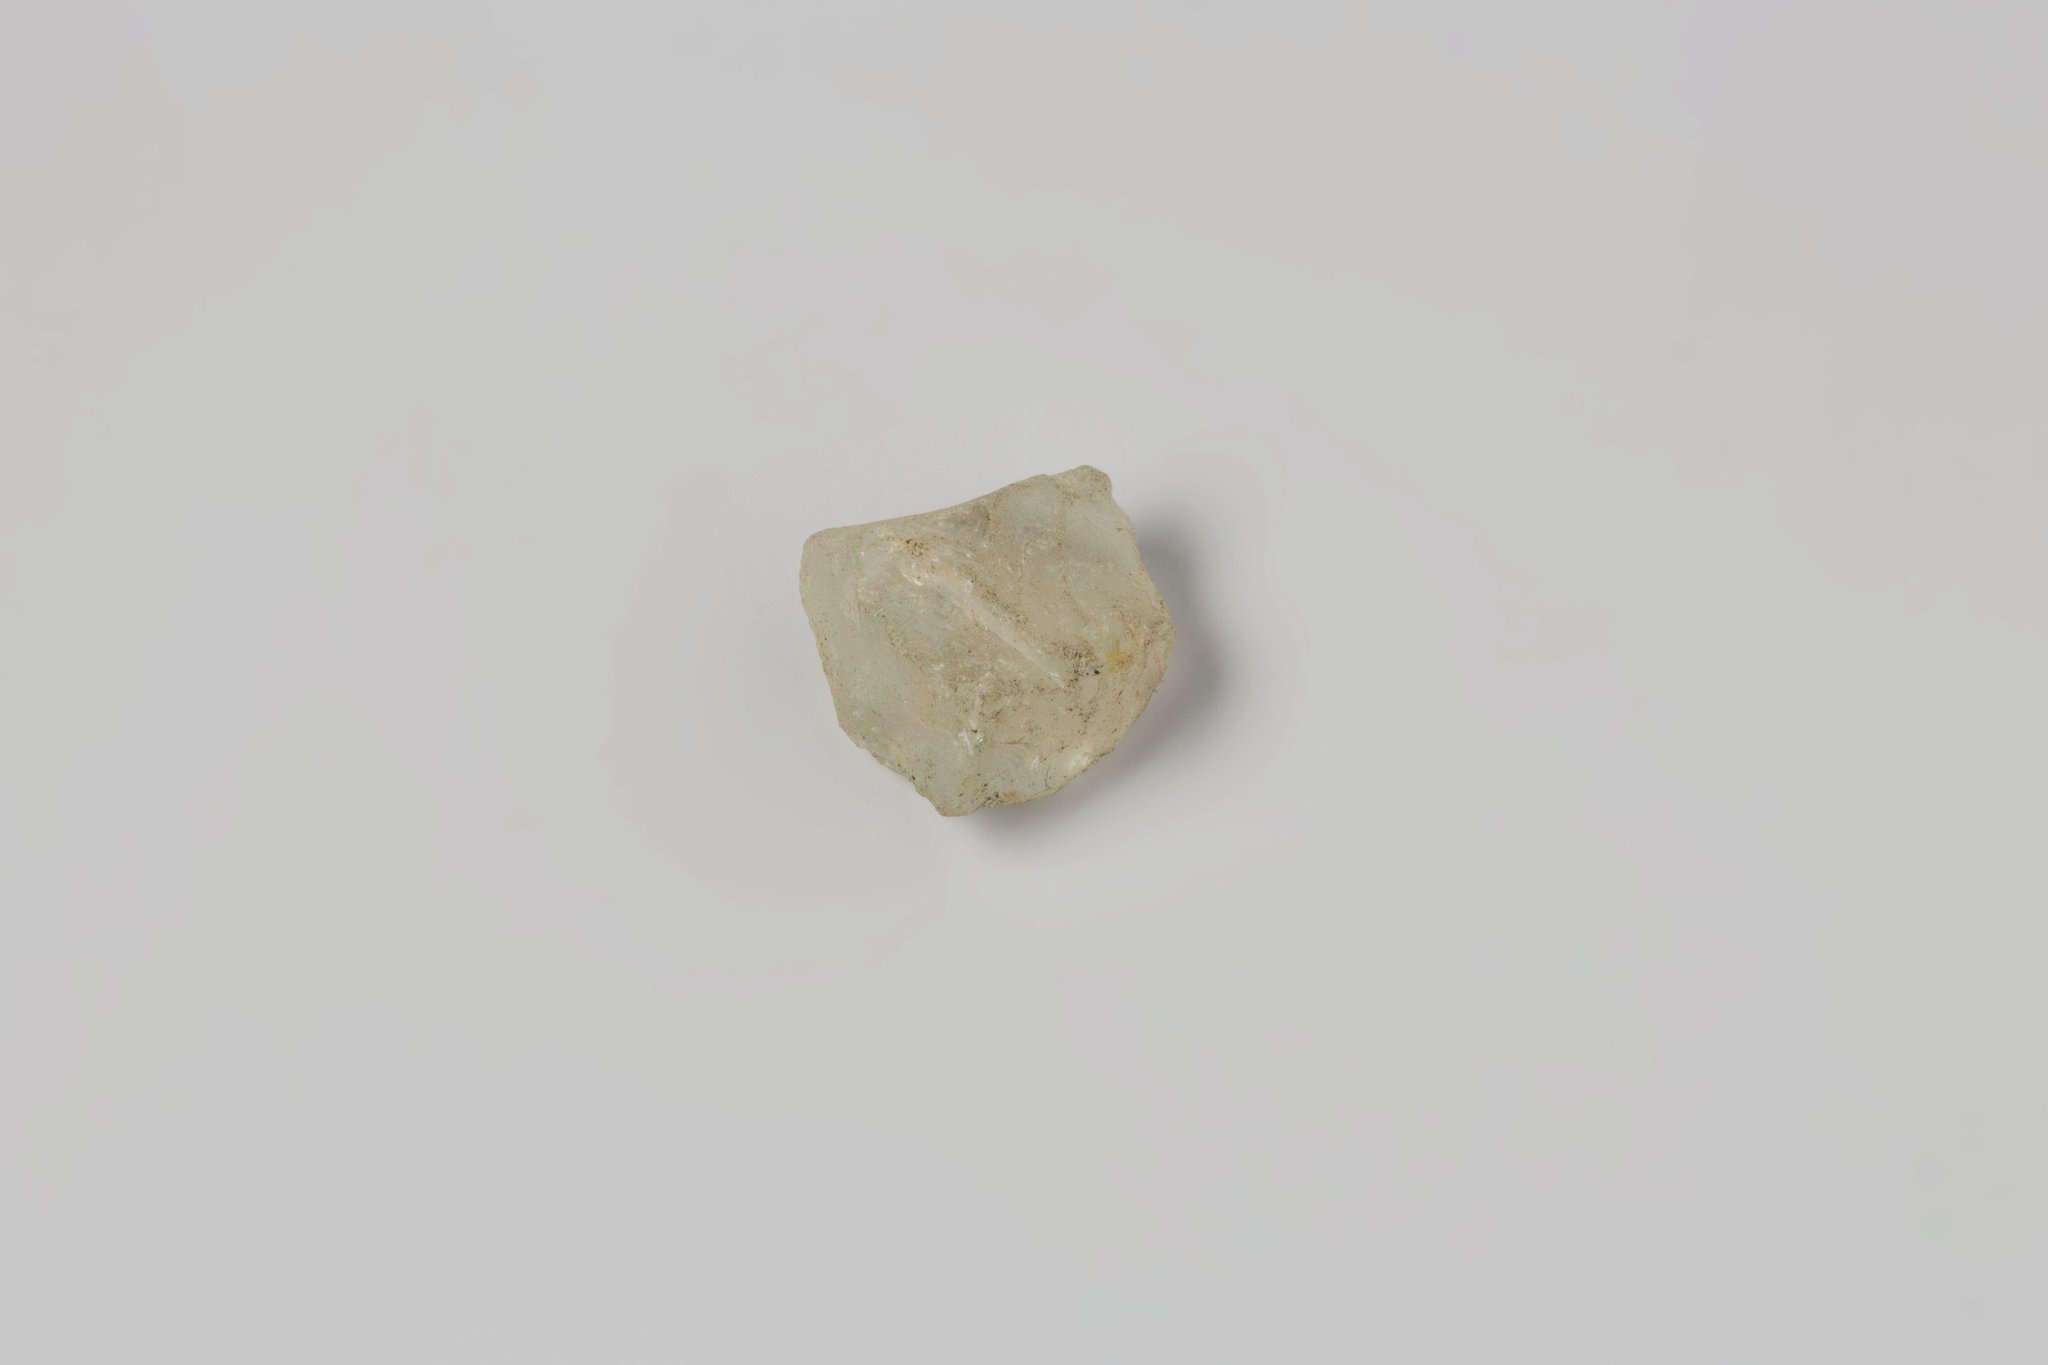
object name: scheepswrakvondst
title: Fragment glas uit het wrak van de Oost-Indiëvaarder Hollandia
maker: Anonymous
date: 1700-1743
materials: glass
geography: netherlands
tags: verenigde oostindische compagnie, hollandia (schip), annet